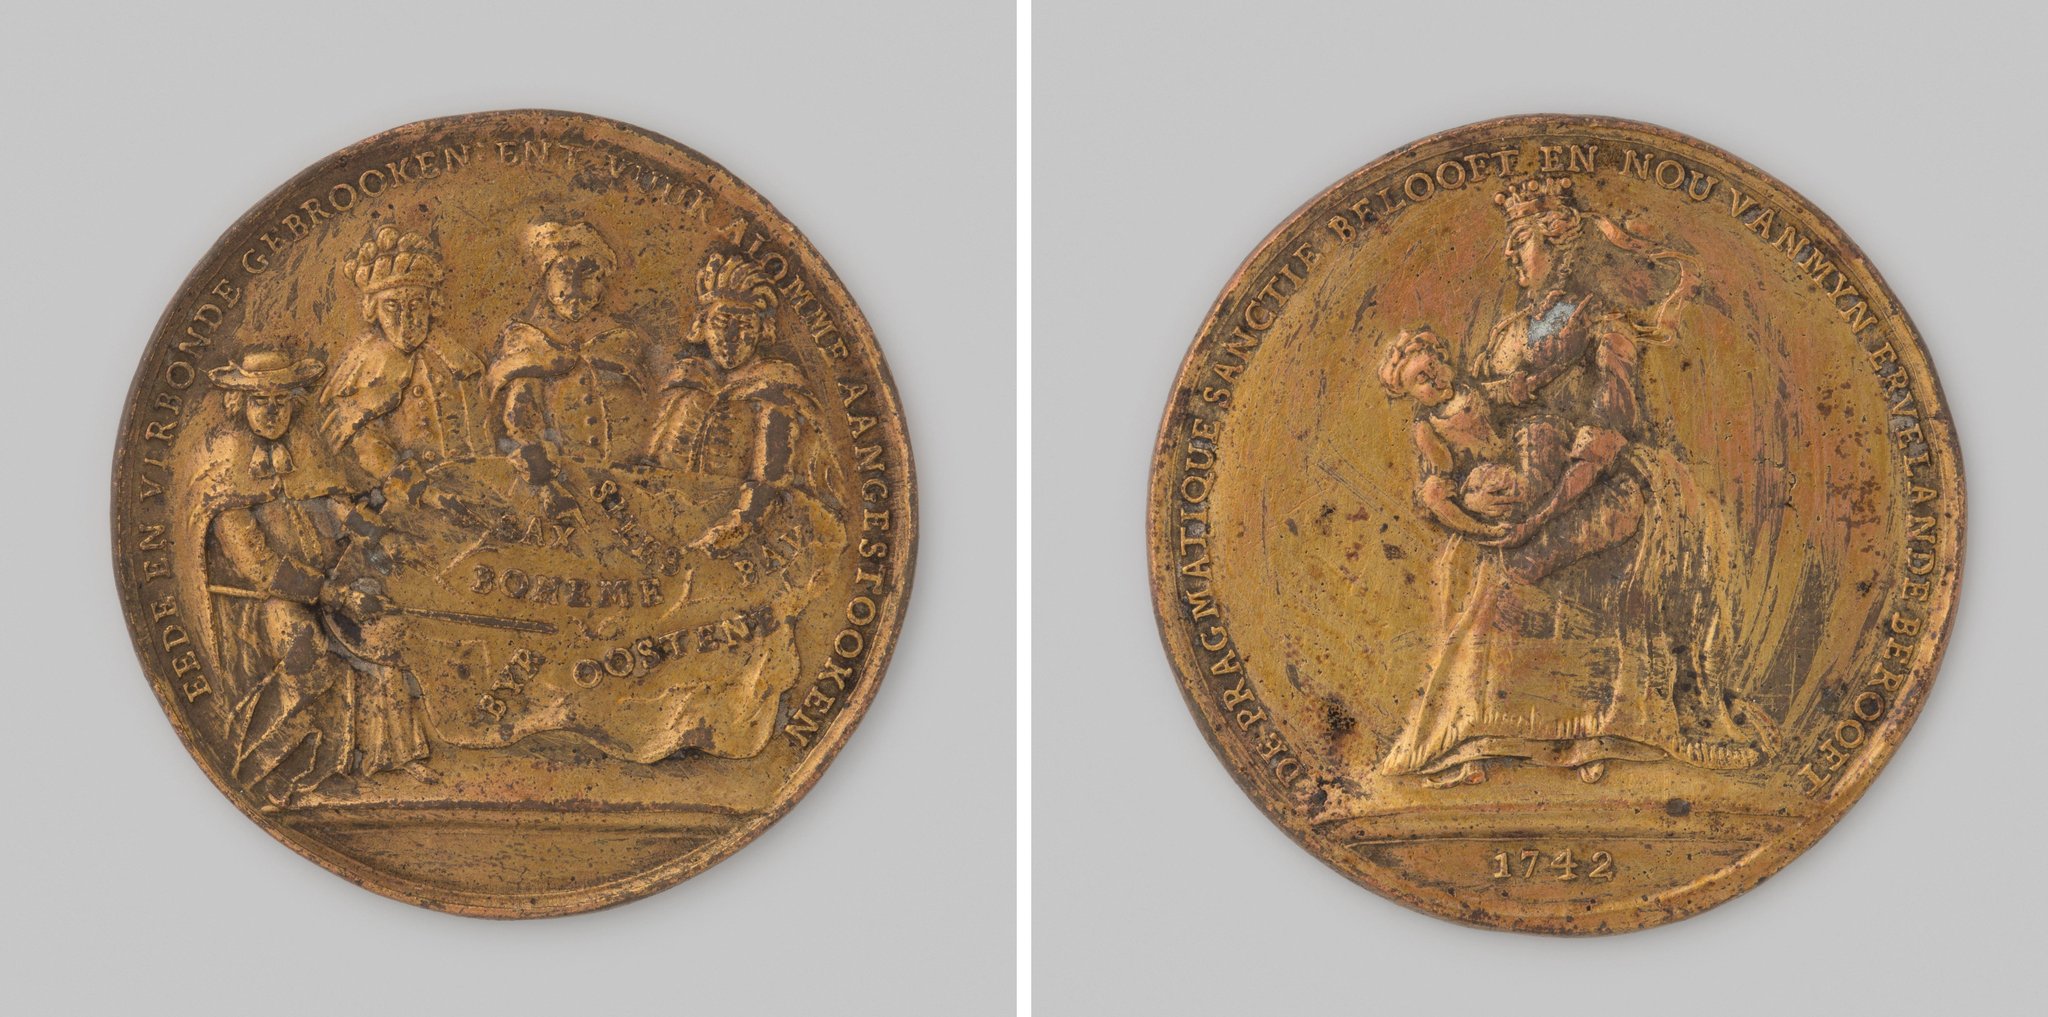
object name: history medal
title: Spotpenning op de Pragmatieke Sanctie 1742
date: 1742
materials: copper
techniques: striking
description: Verguld koperen penning, op de voorzijde vier staatslieden bij een landkaart, met omschrift, op de keerzijde een staande koningin met kind, met omschrift.